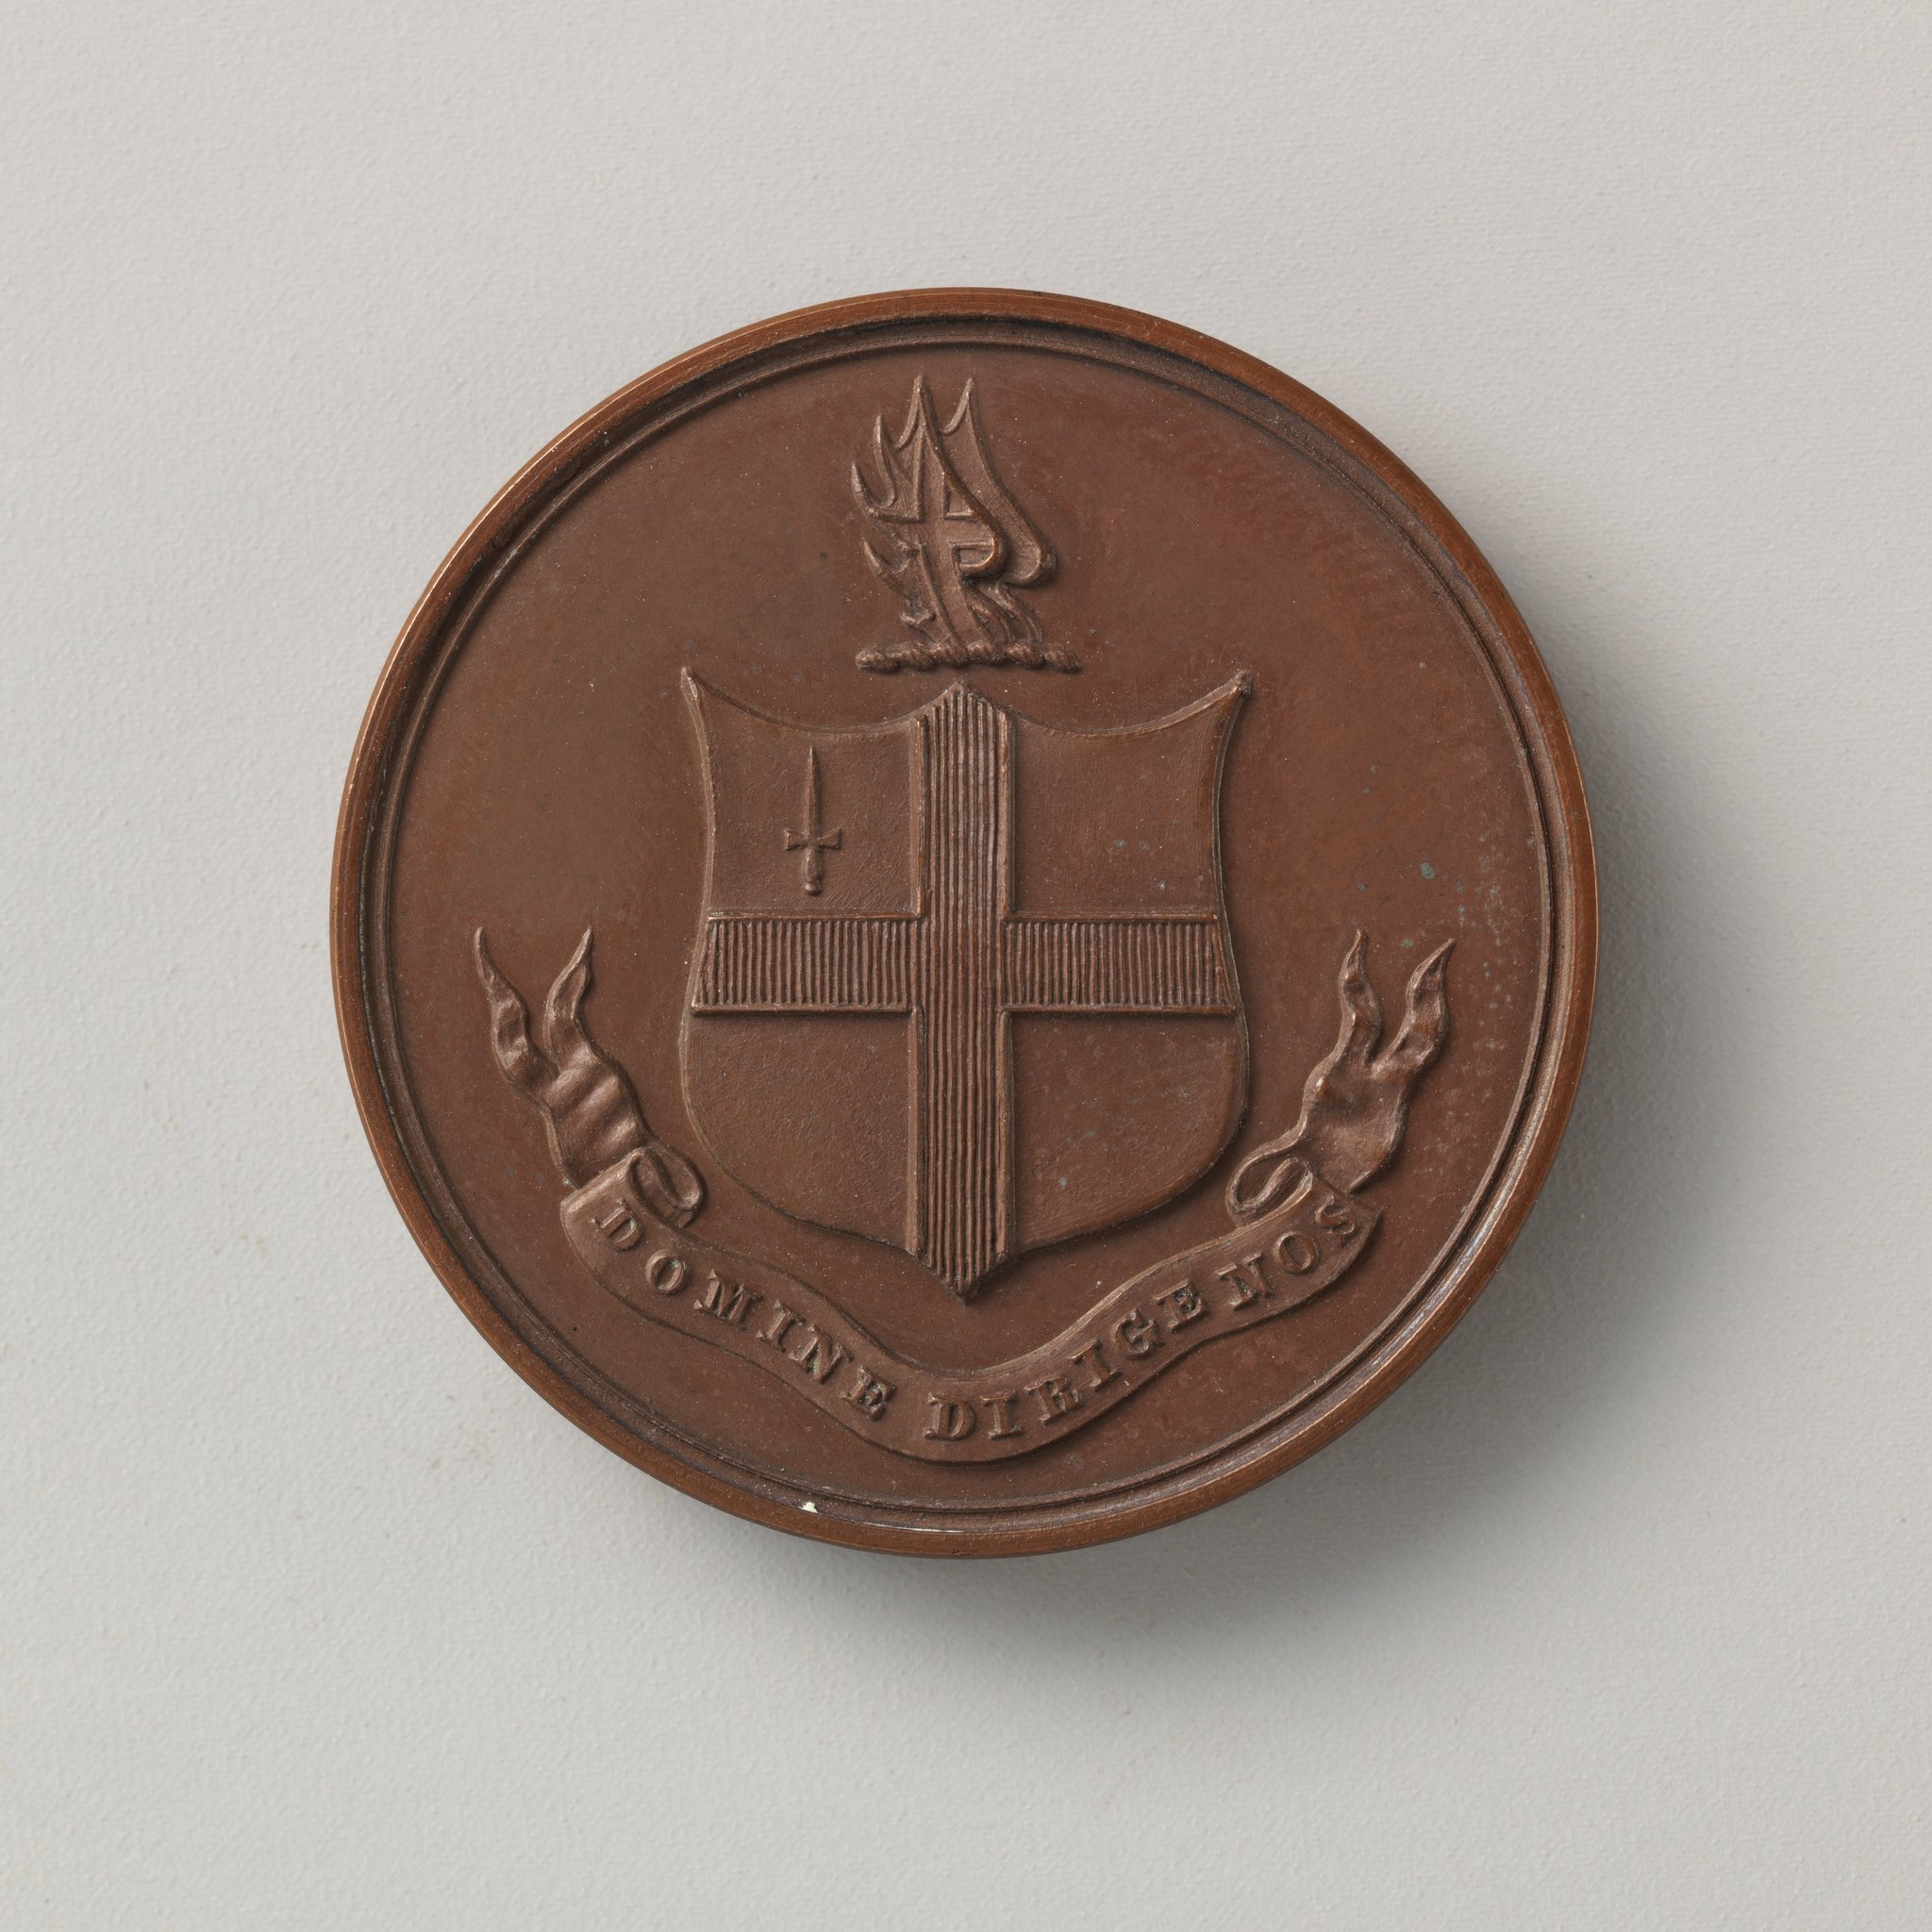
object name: token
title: To Commemorate the Opening of the New London Bridge, by King William IV and Queen Adelaide, August 1, 1831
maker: benjamin wyon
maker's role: artist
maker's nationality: british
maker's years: 1802-1858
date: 1831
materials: bronze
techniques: struck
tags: coat of arms